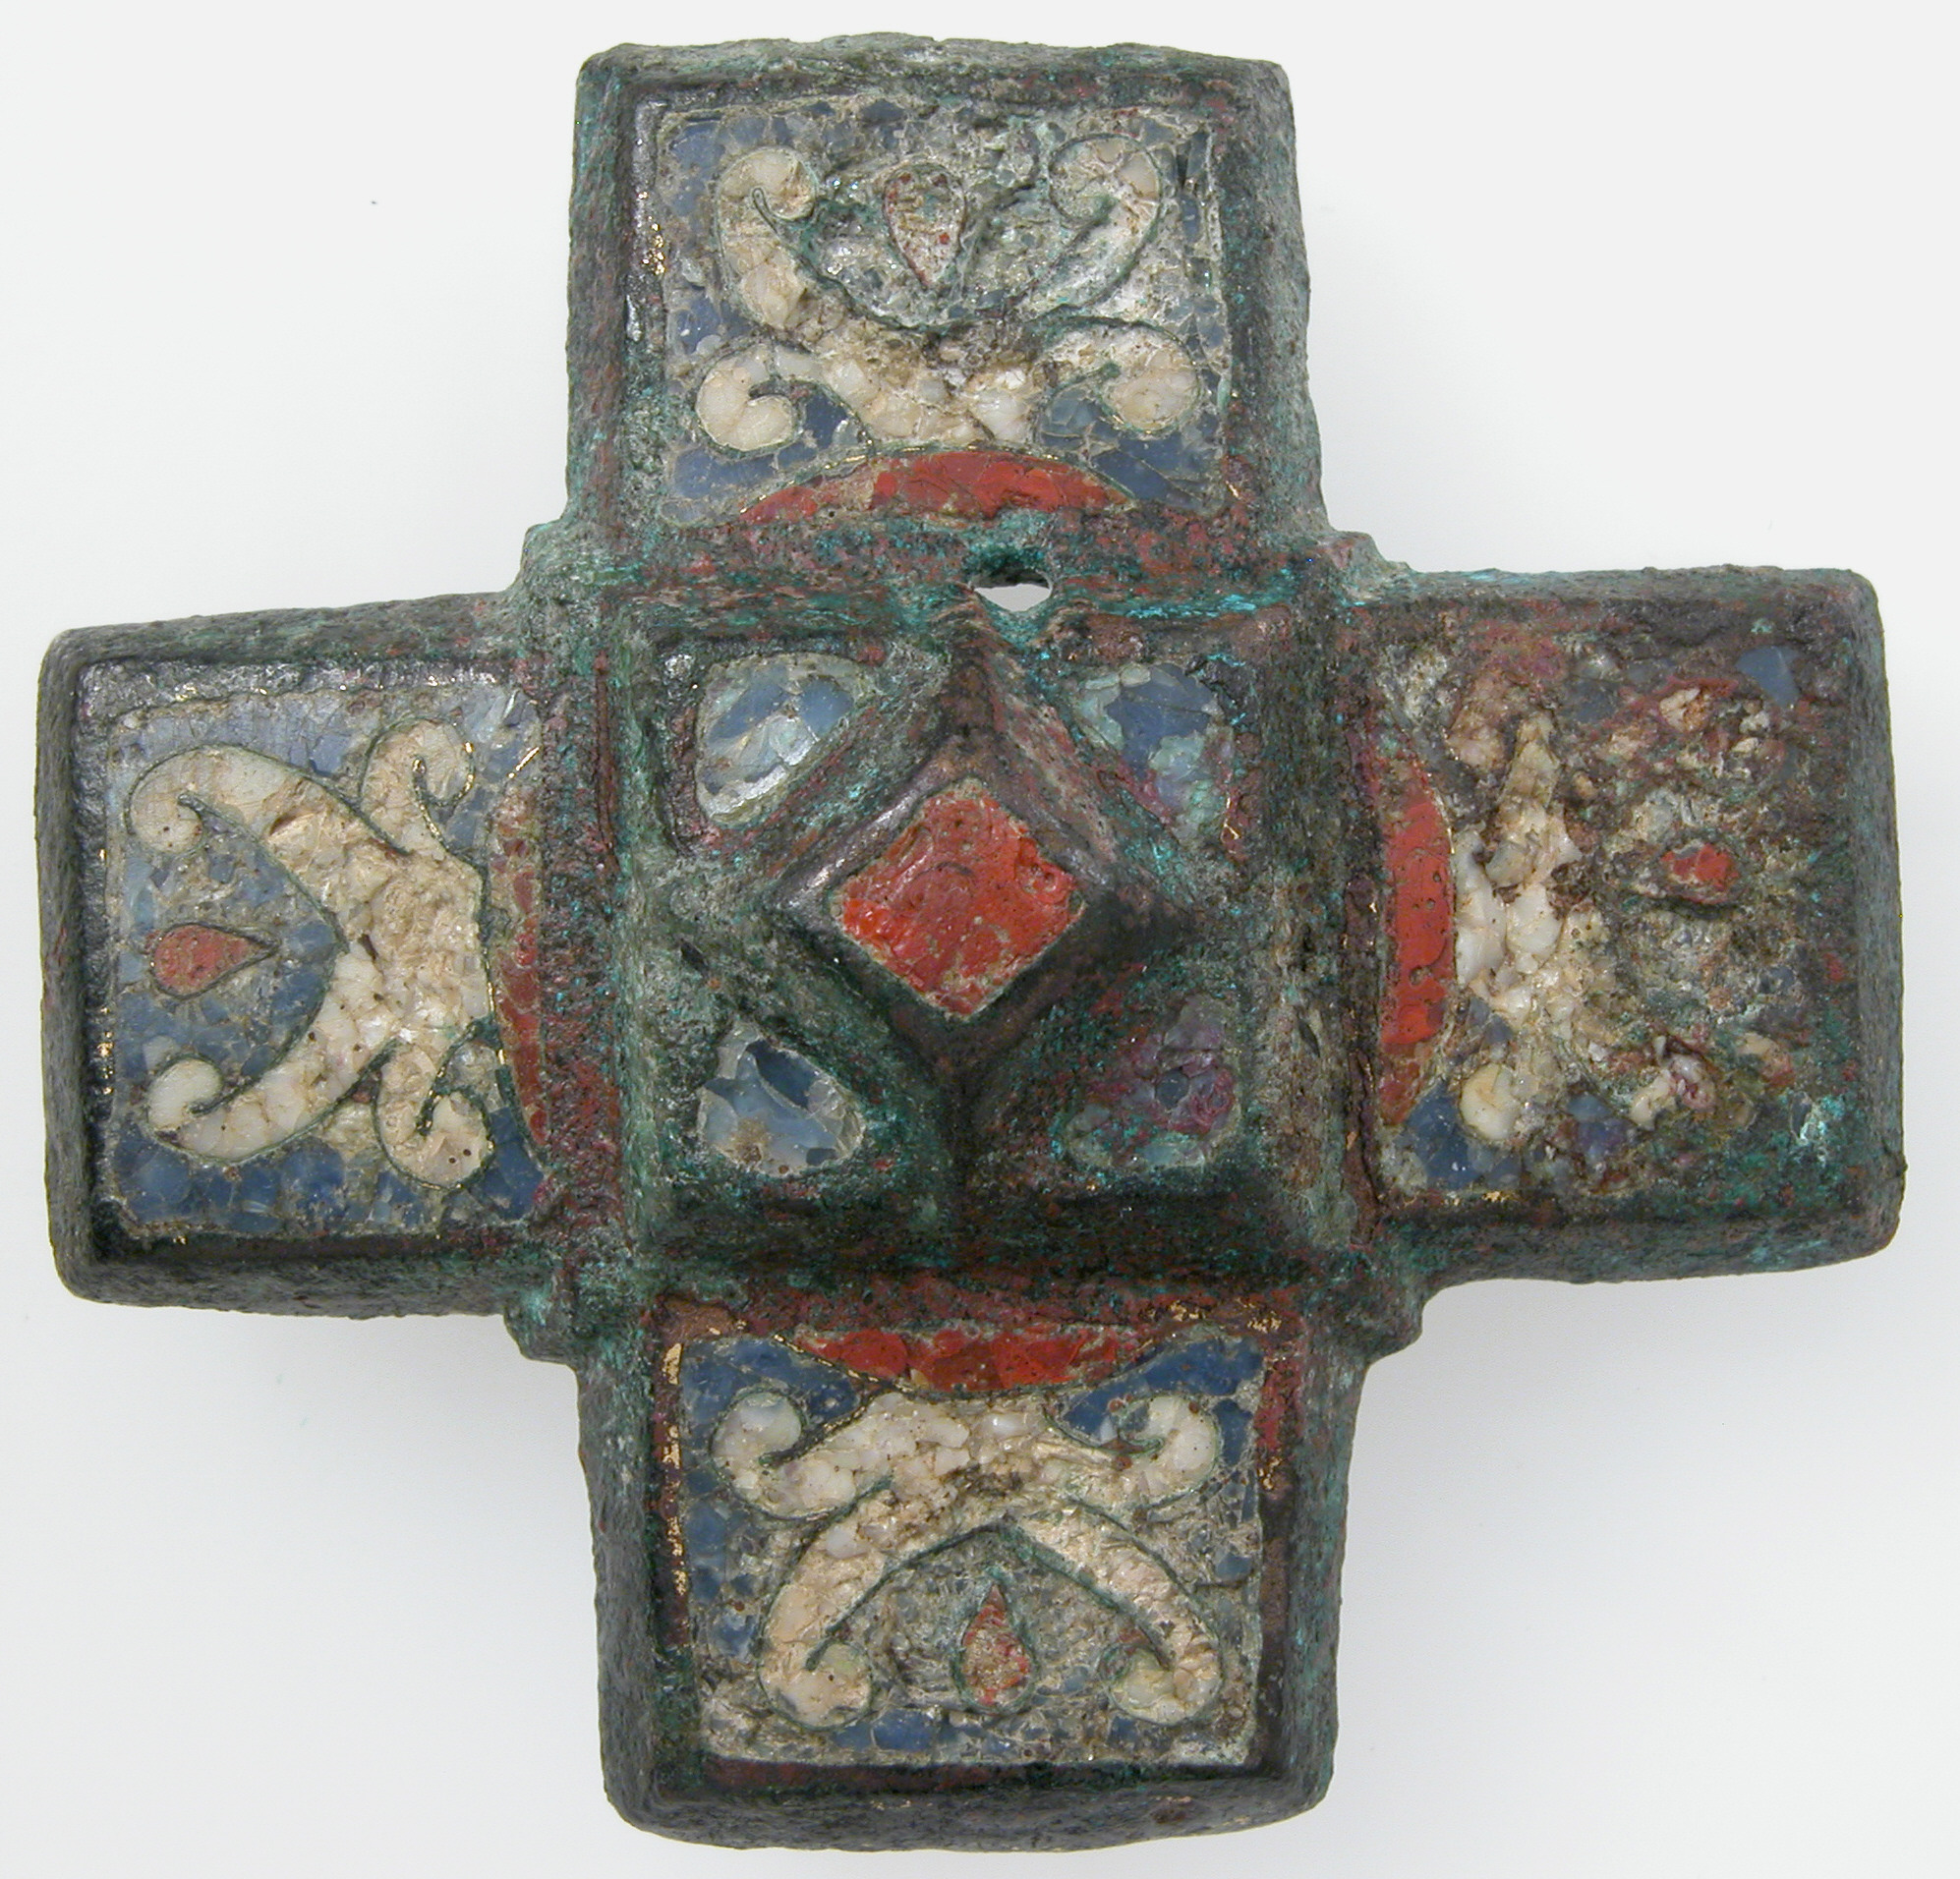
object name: harness mount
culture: german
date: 901-1000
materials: bronze, enamel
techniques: enamel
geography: germany